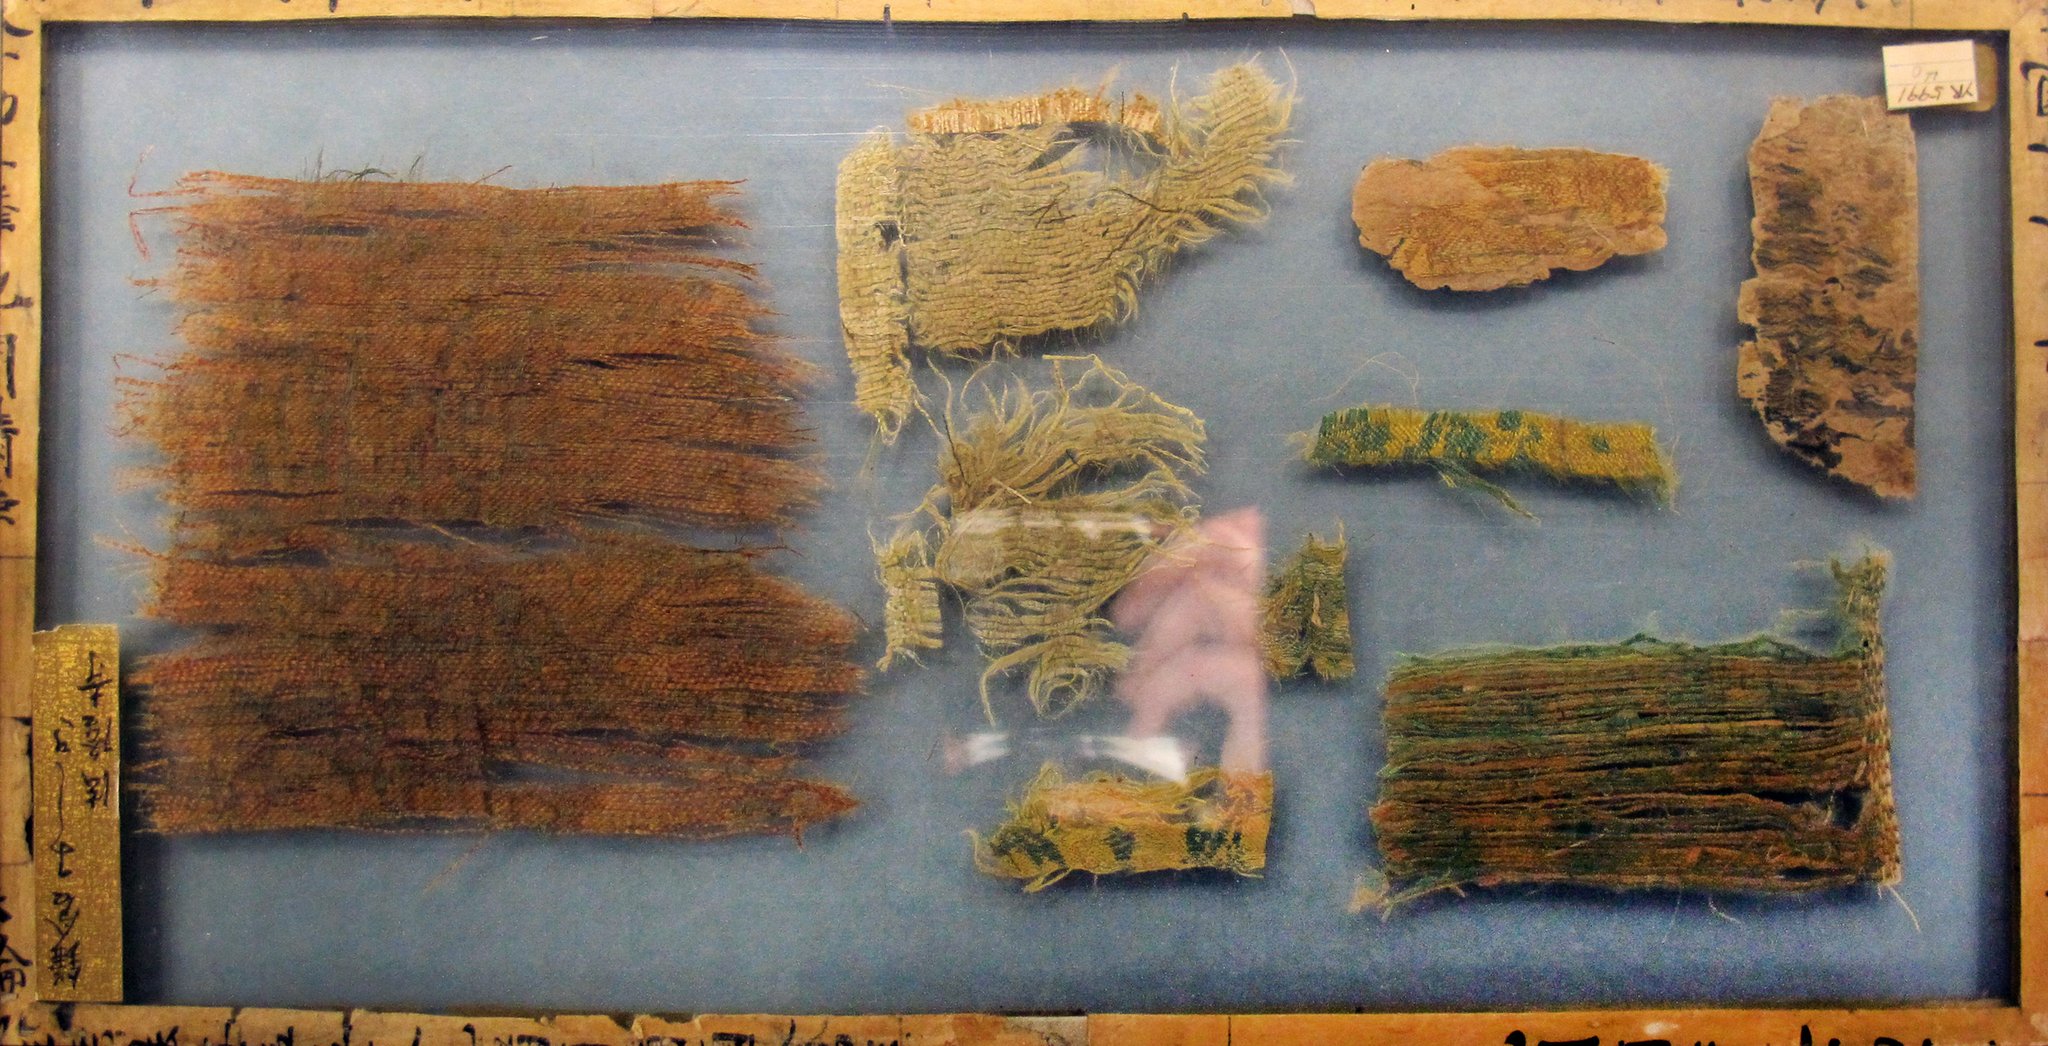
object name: fragment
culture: japanese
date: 701-800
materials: textile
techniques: weave